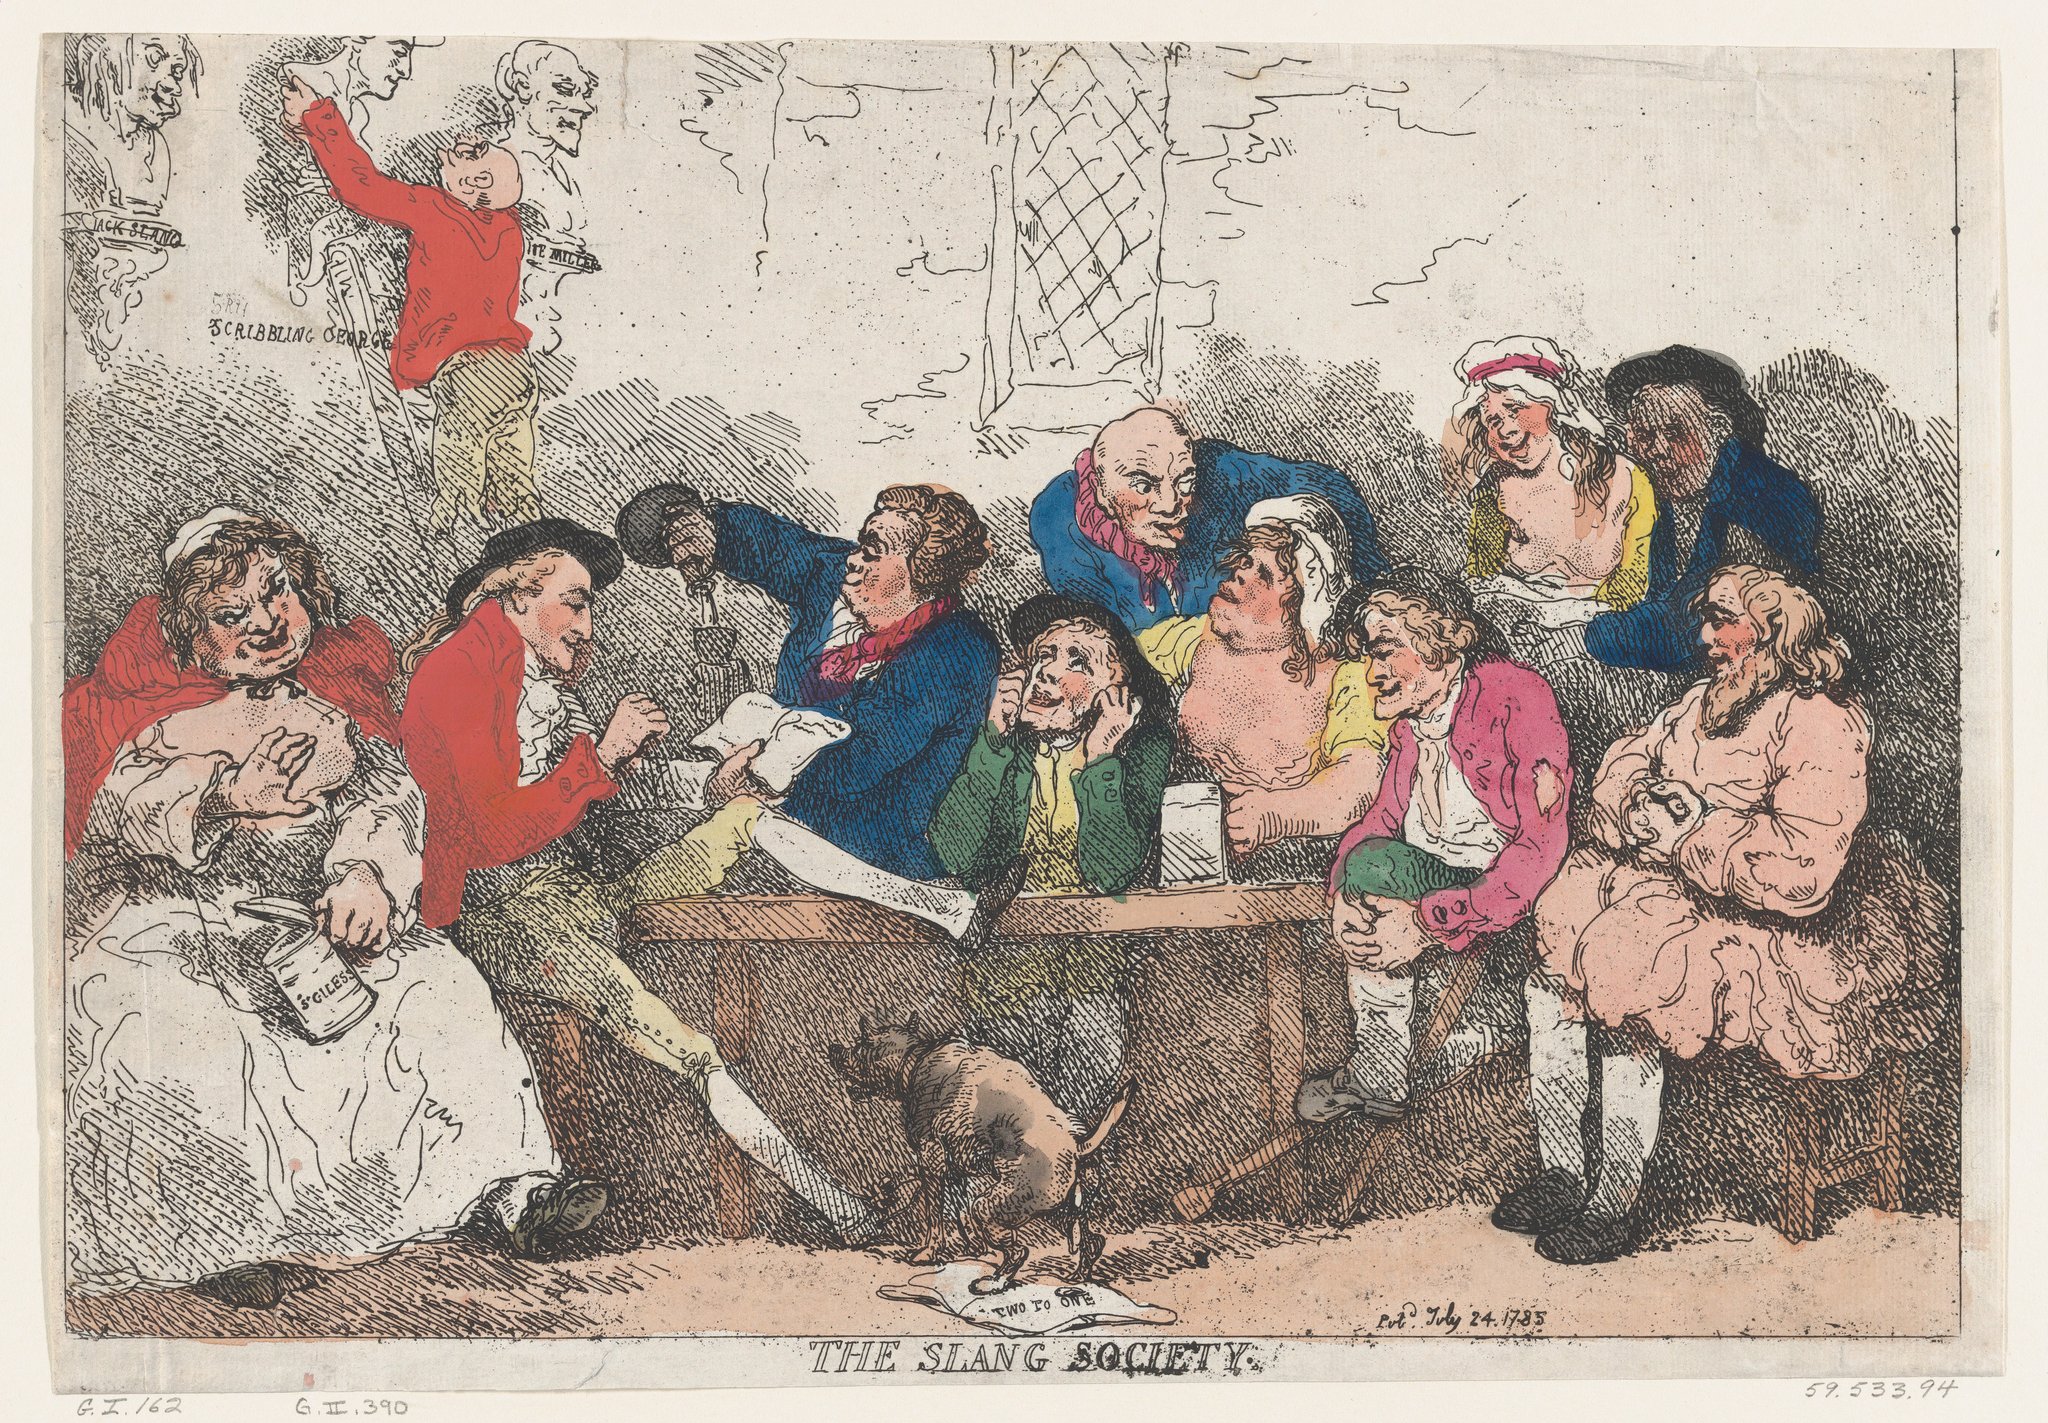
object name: print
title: The Slang Society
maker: thomas rowlandson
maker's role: artist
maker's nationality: british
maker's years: 1757-1827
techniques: etching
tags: satire,drunkenness,men,women,dogs